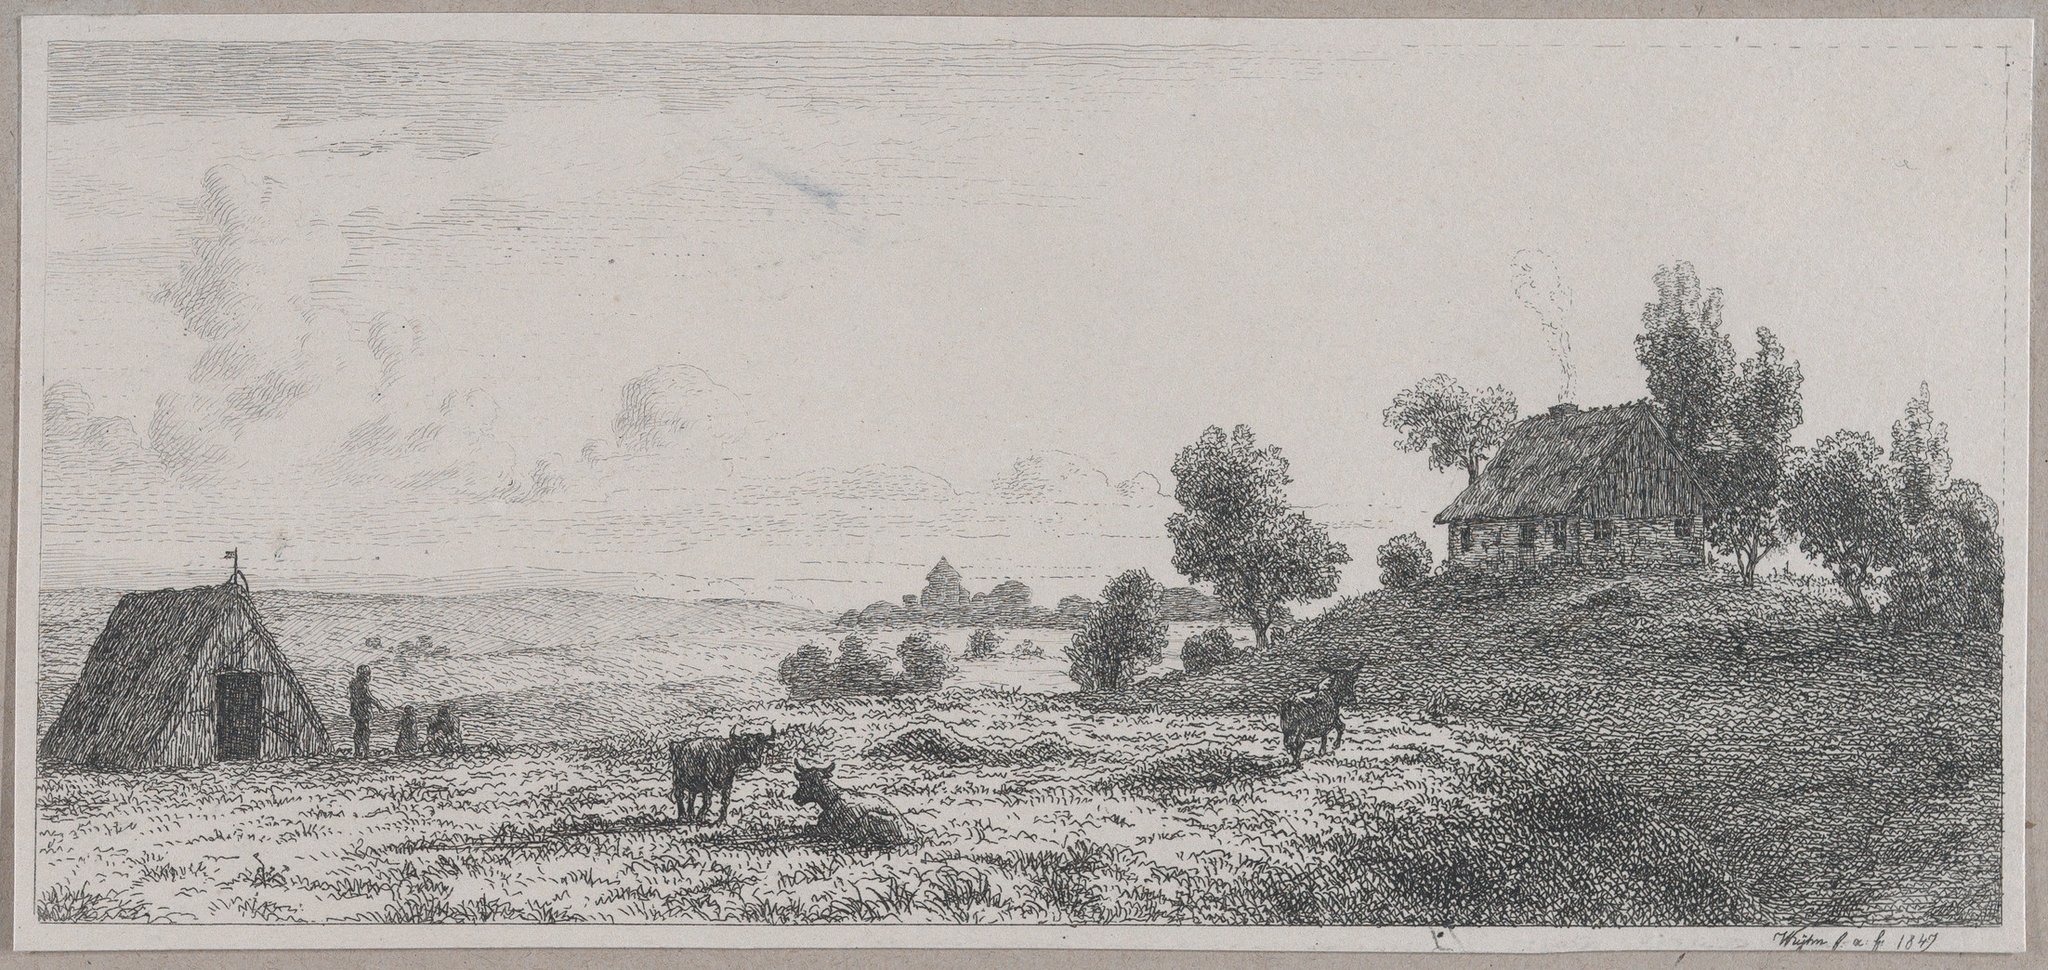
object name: print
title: Rural View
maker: peter vilhelm carl kyhn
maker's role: artist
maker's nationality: danish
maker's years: 1819-1903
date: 1847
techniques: etching